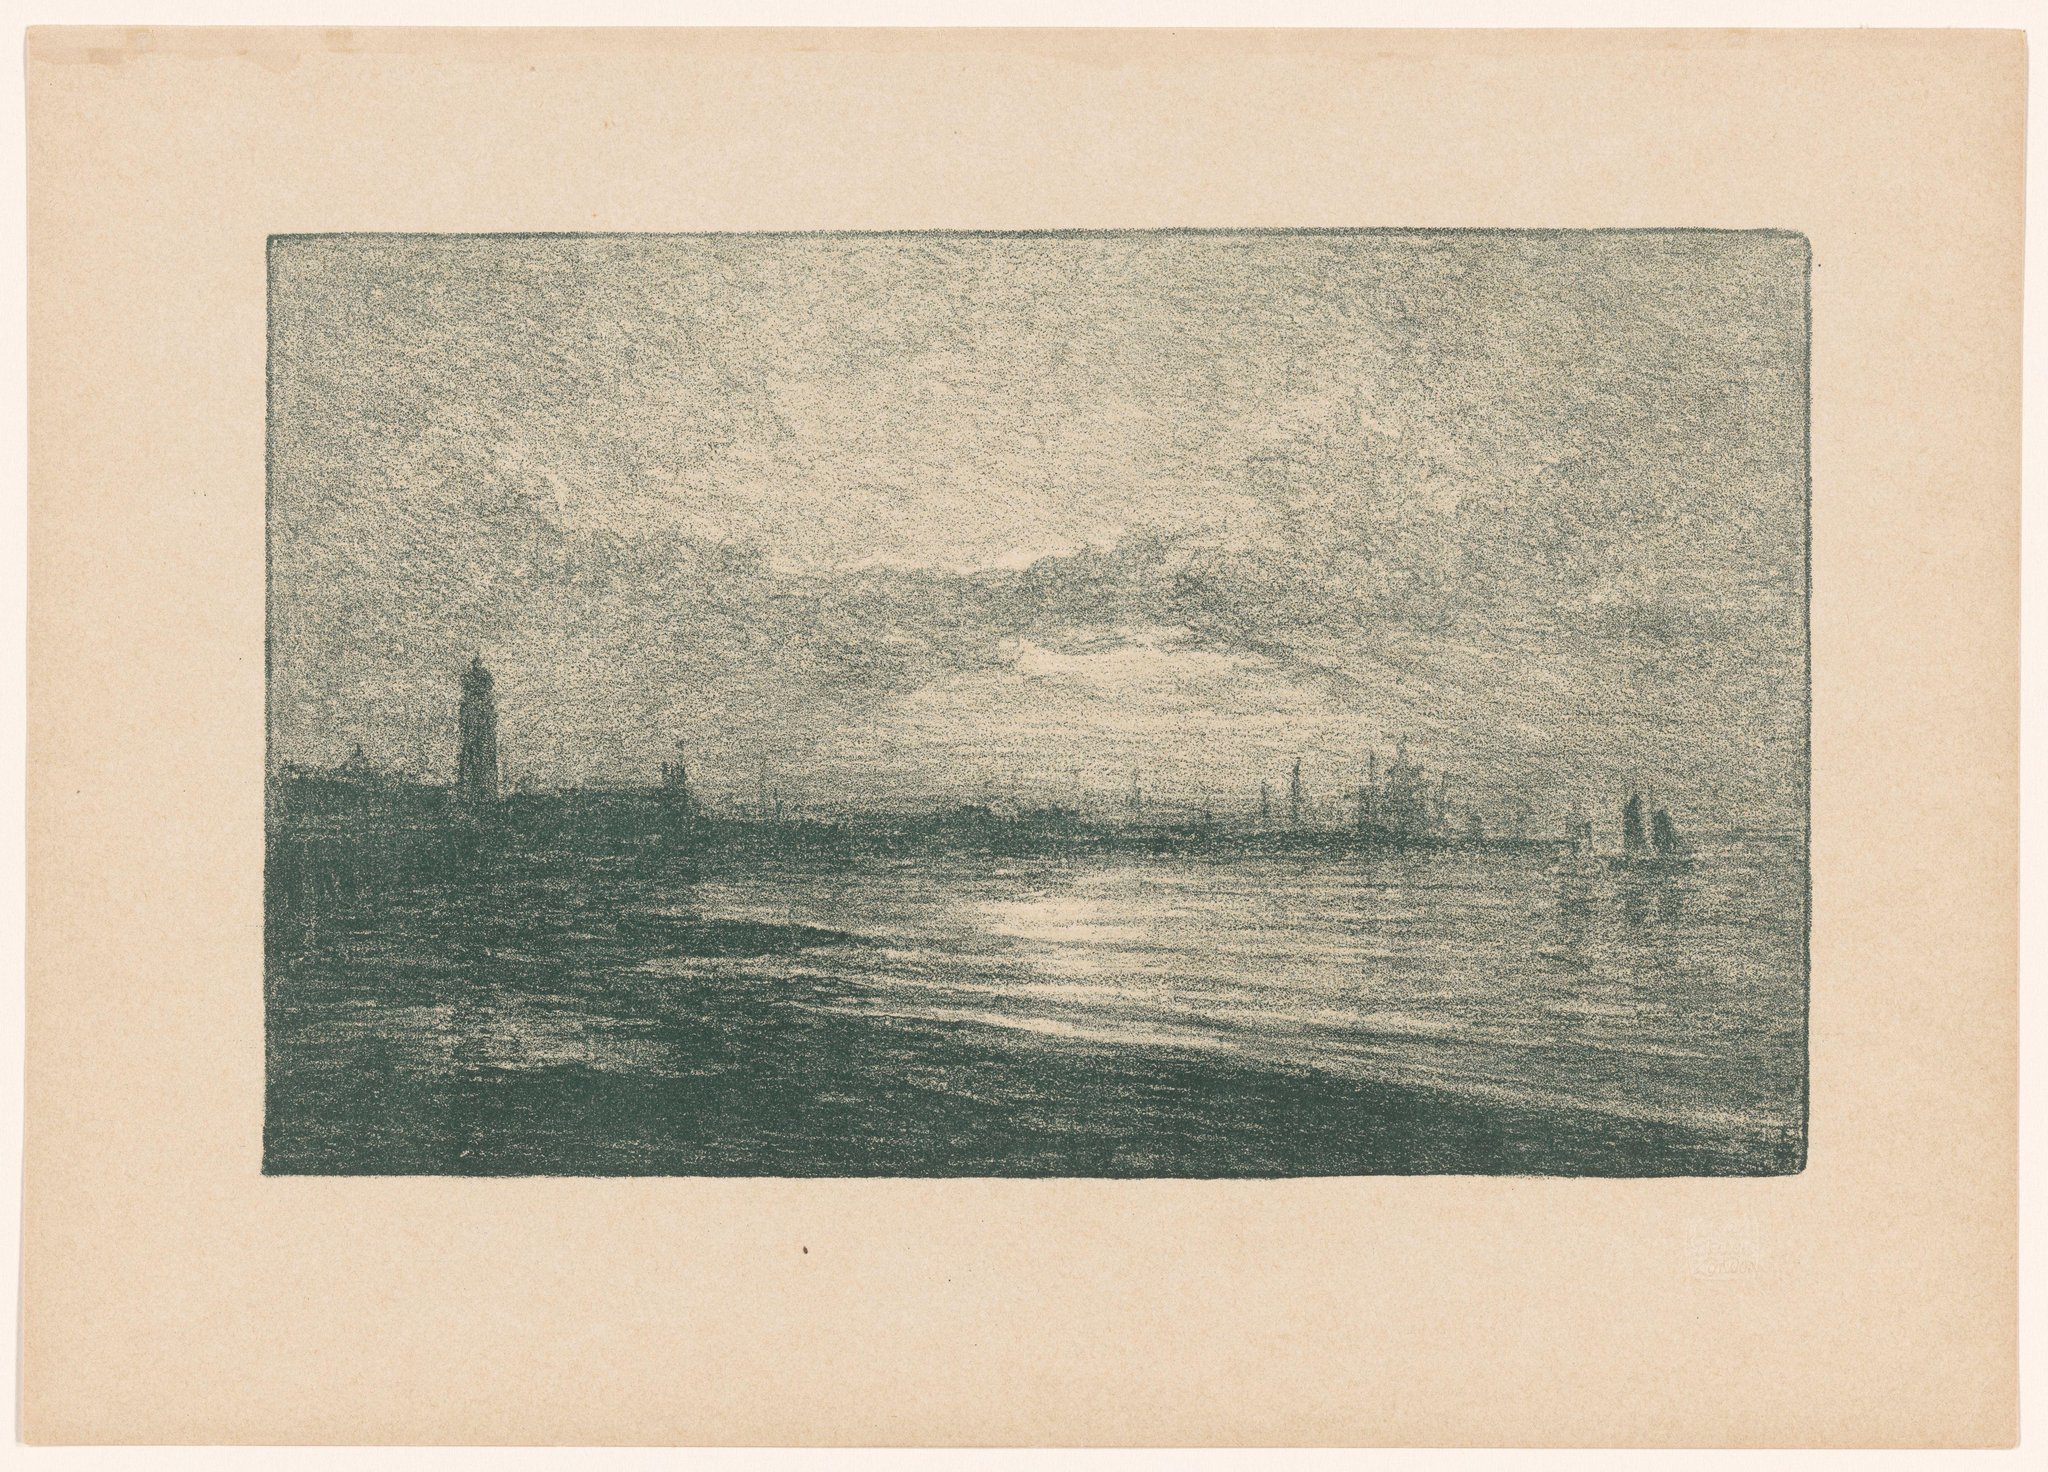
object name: print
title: Zeehaven bij avond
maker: carel nicolaas storm van s-gravesande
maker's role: draughtsman, print maker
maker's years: 1841-1924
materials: paper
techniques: lithograph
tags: harbour, evening, coast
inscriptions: inscription: ‘Decline of Day/ An original algraph by Storm v. 's Gravesande/ uit The Studio 15 Sept 1897.’, collector's mark: Lugt 2322bis, collector's mark: Lugt 2228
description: Mogelijk vermeld in: Storm van 's-Gravesande, Charles. Catalogue des eaux-fortes et lithographies. New York: s.n., 1903, of in een onbekende latere uitgave van het manuscript. Vermoedelijk vermeld als catalogusnummer 59.